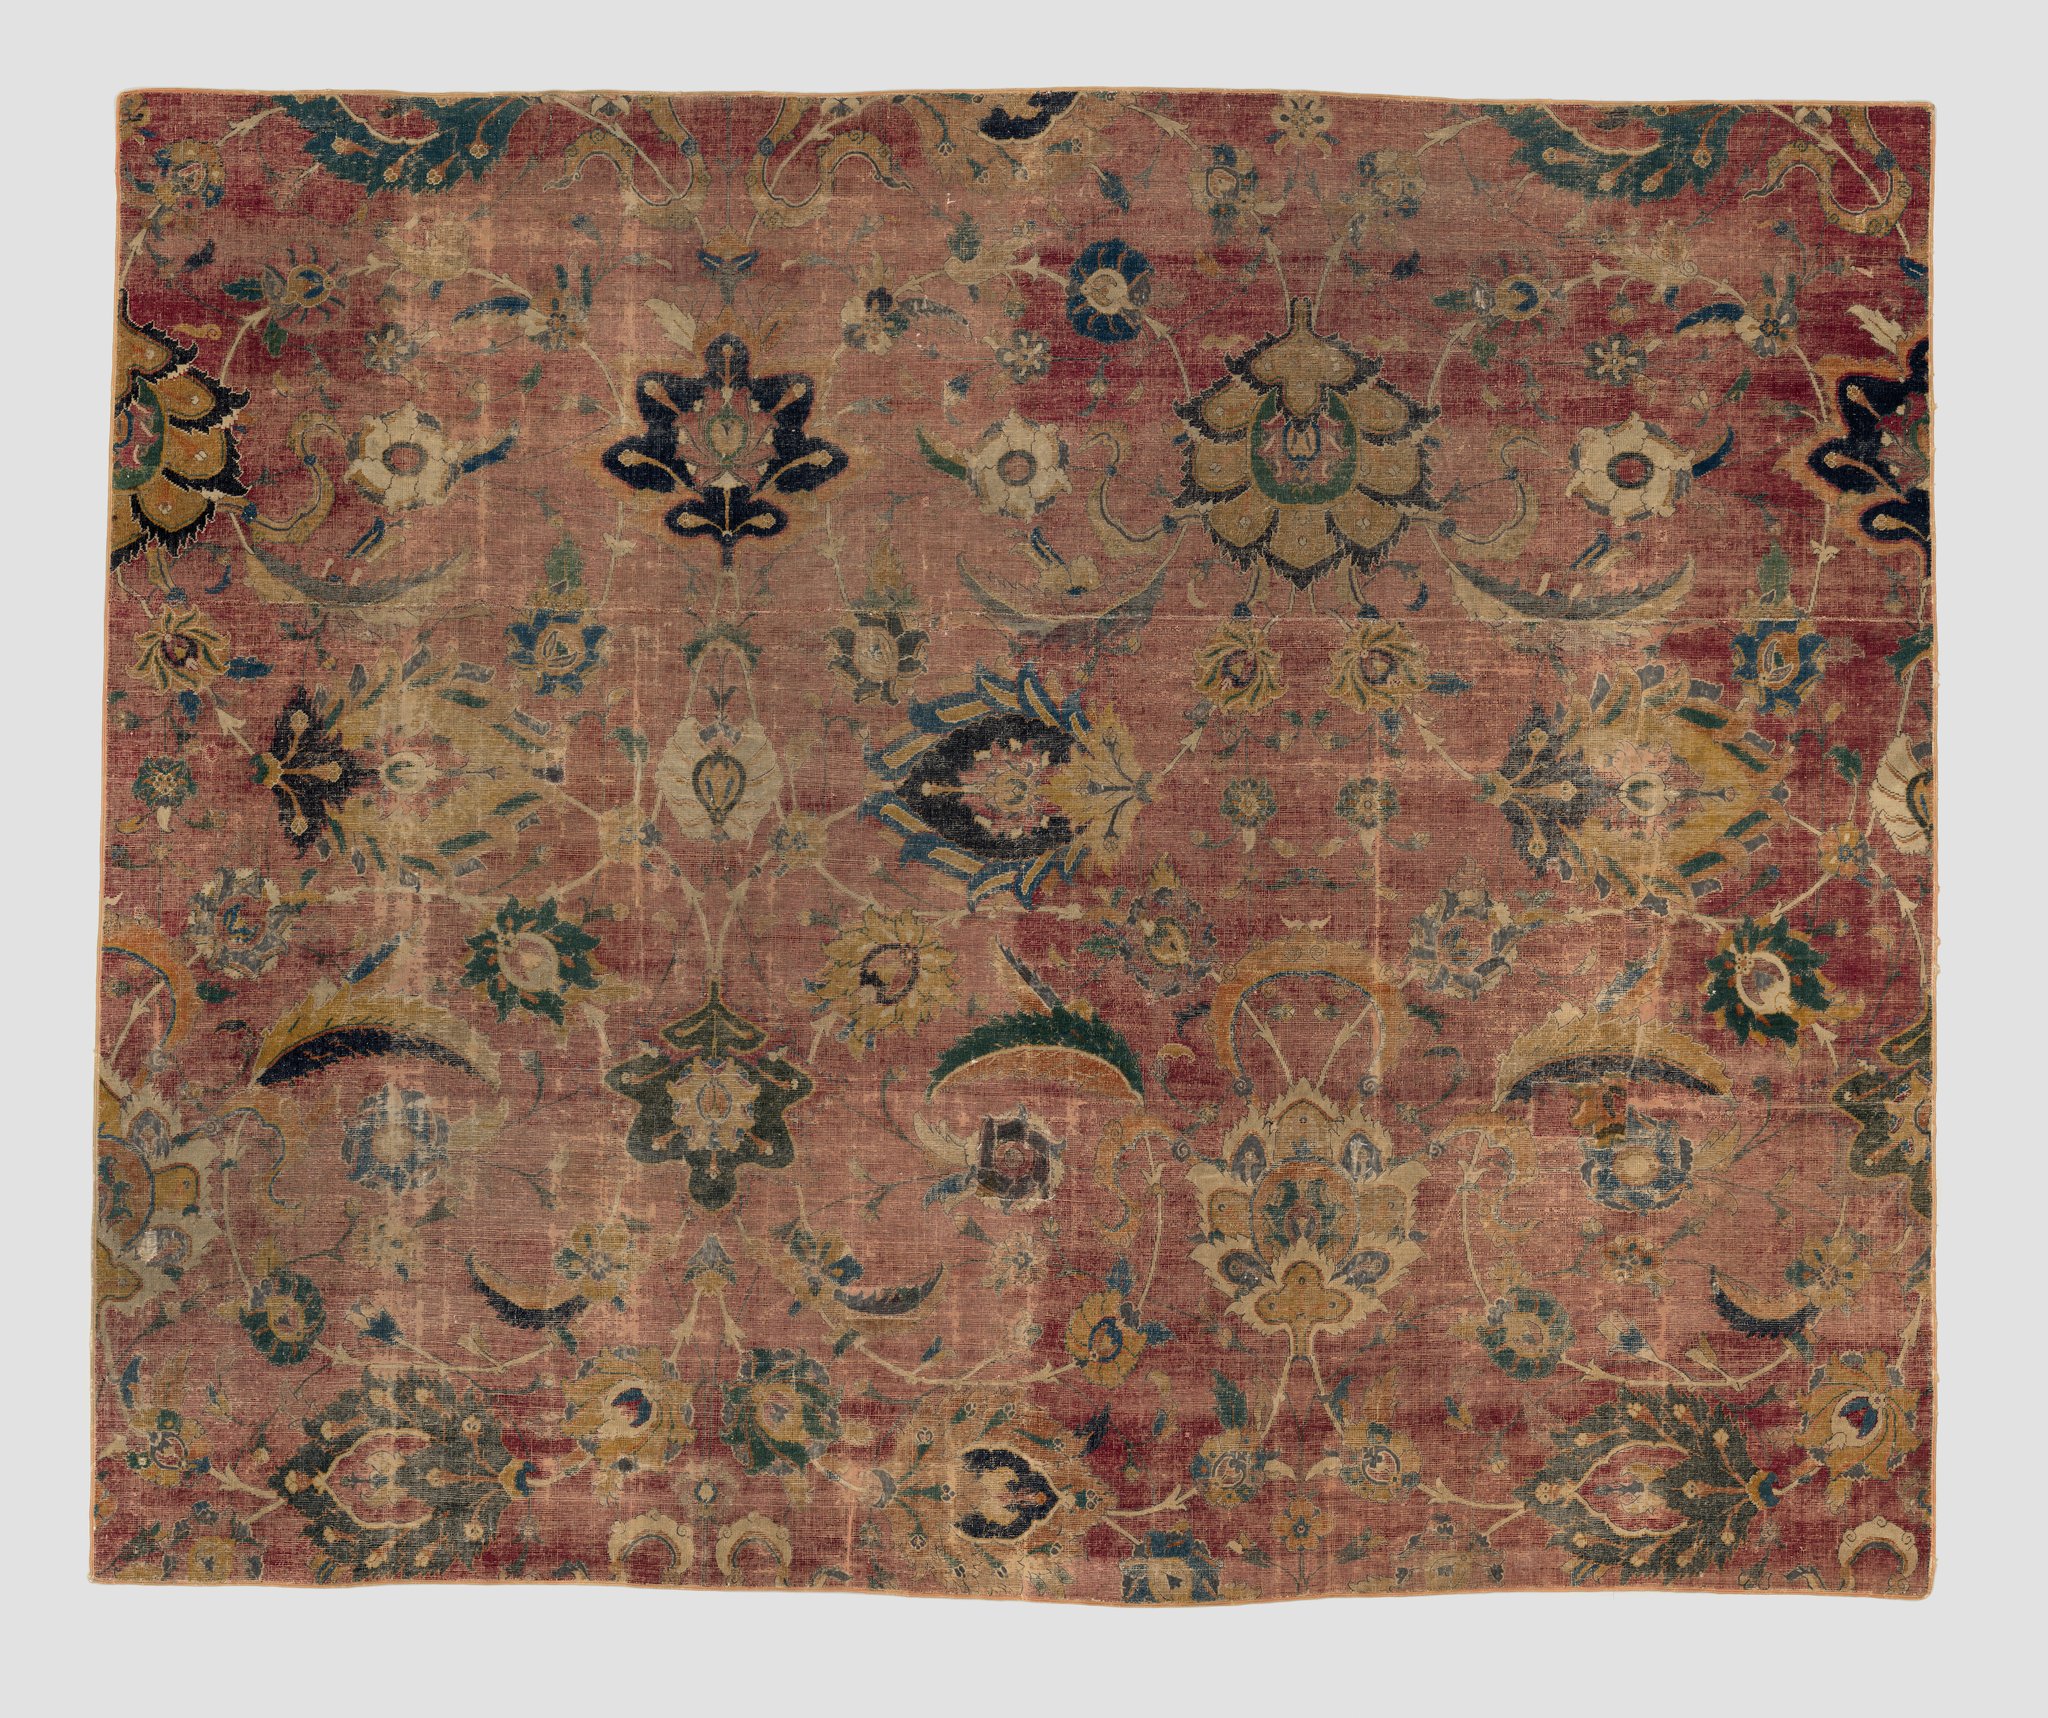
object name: carpet fragment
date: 1601-1700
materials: wool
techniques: asymmetrically knotted pile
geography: iran